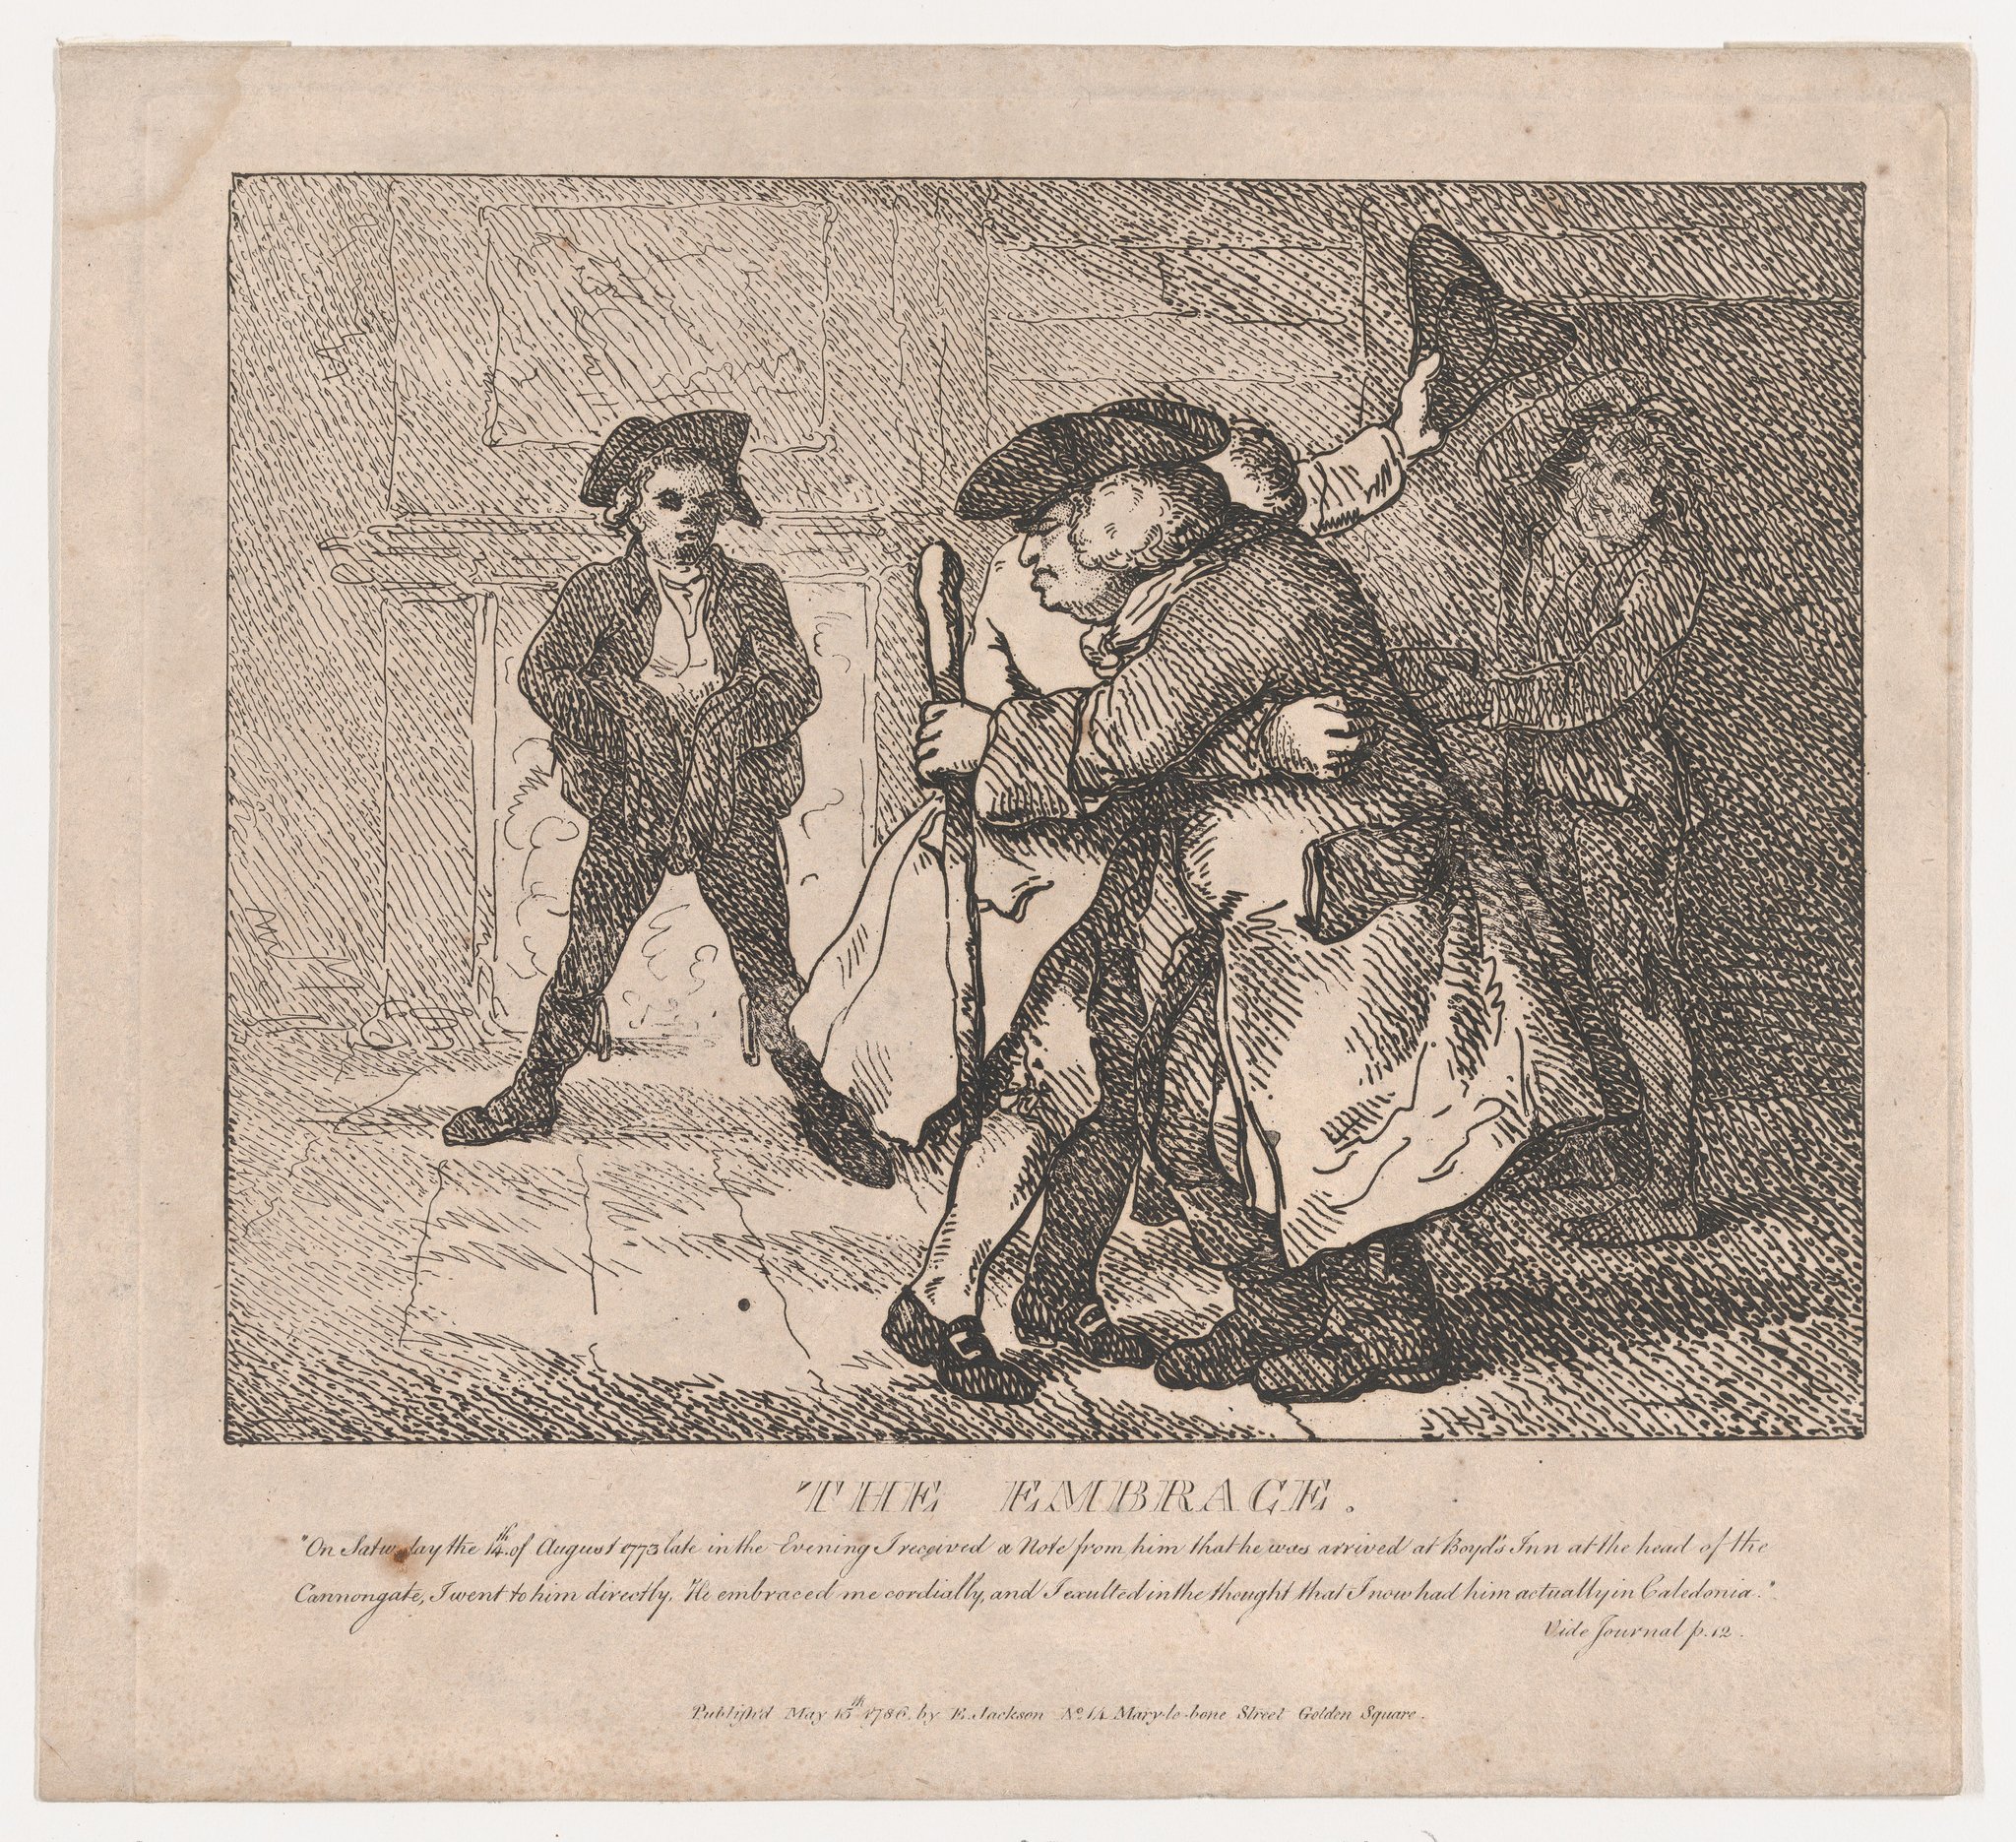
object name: print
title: The Embrace (Picturesque Beauties of Boswell, Part the First)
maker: thomas rowlandson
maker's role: artist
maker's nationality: british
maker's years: 1757-1827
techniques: etching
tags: satire,men